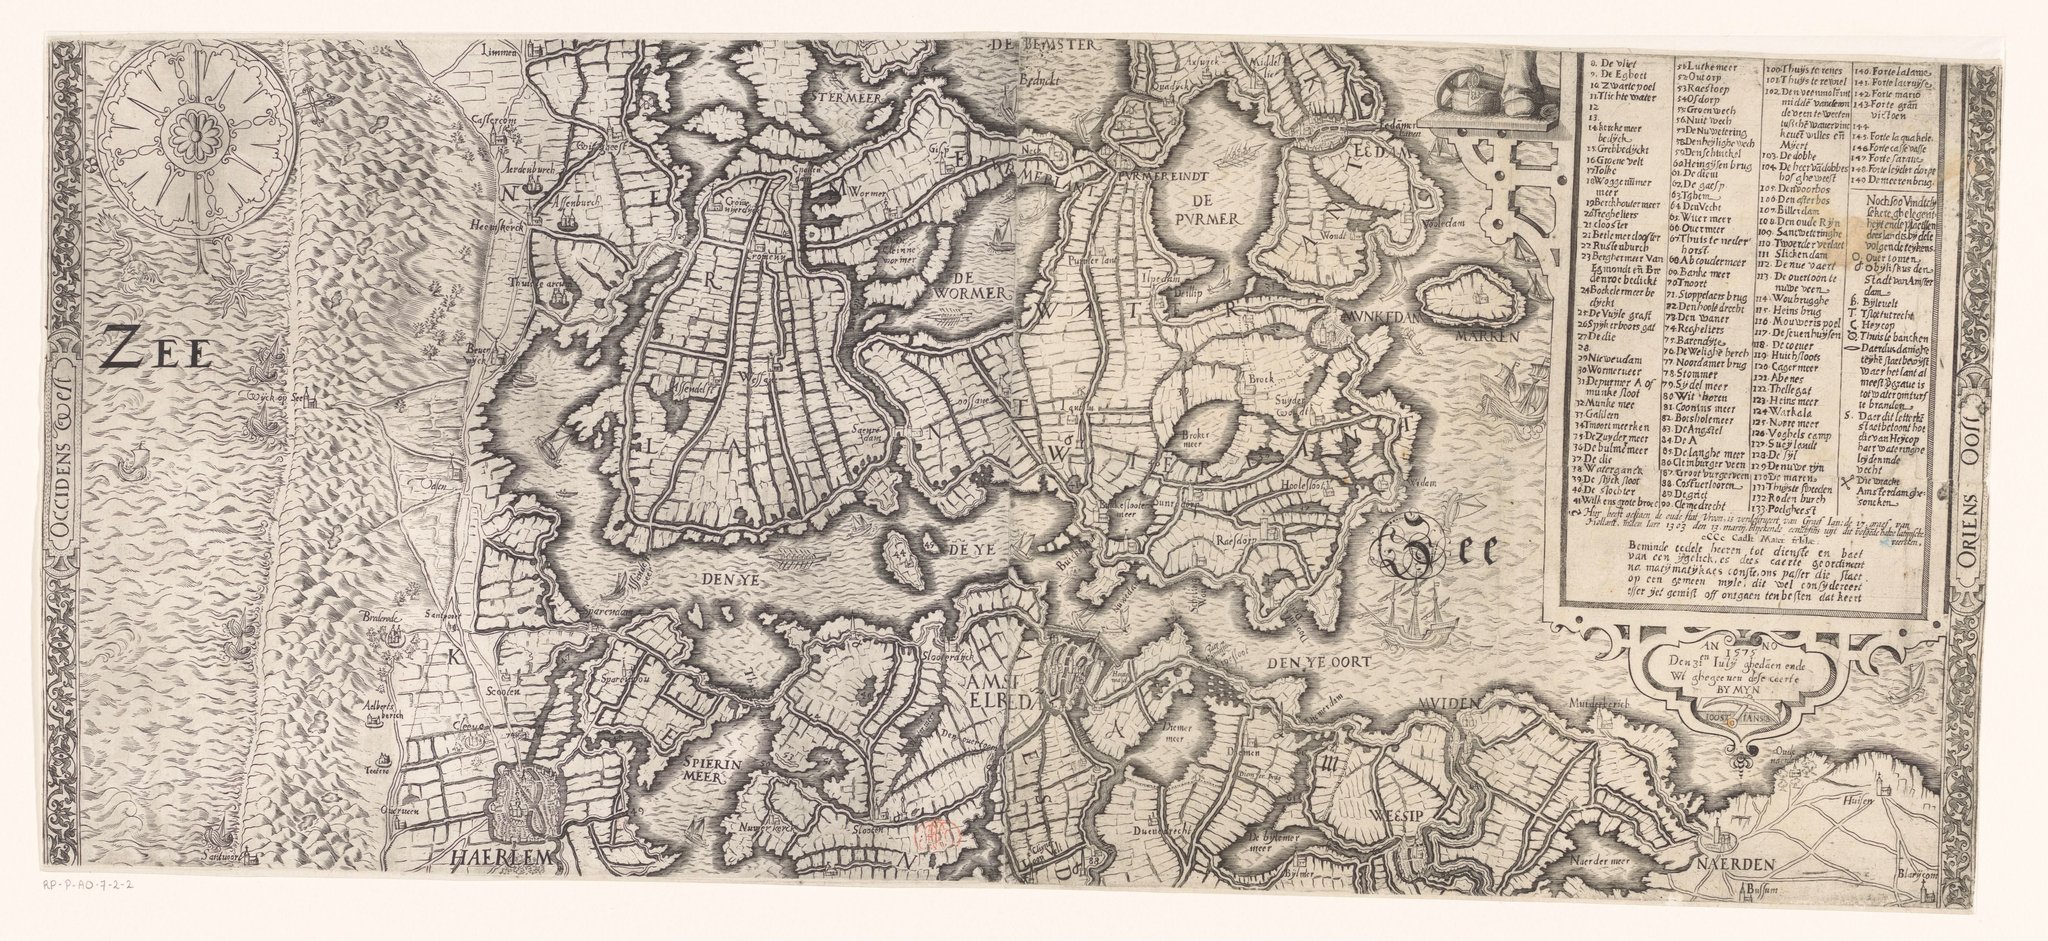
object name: print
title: Caerte van Noorthollant beghinende van Noortendt, Zuytwarts up tot om Leyden toe; voorts streckende Oostwaerts tot om Utrecht weder Noortwarts up in de Zuider Zee met alle sijn steden, dorpen, dijcken, weghen, wateren en vaerten, daer inne begrepen elcx na syne rechte ghelegheth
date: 1575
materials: paper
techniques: engraving, etching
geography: netherlands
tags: maps of separate countries or regions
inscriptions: collector's mark: Lugt 195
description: Van de eerste staat van deze kaart, die in 1575 werd uitgegeven door Joost Jansz. Bilhamer (ook wel Joost Jansz. Beeldsnijder of Bilham genoemd), zijn geen exemplaren bekend. De huidige staat werd in 1608 uitgegeven door Herman Allertsz. Koster van Warmenhuizen. Bij deze uitgave hoort een sierrand, voorzien van een uitgebreide historische en contemporaine beschrijving van het gebied in boekdruk en etsen gemaakt door Claes Jansz. Visscher (II).